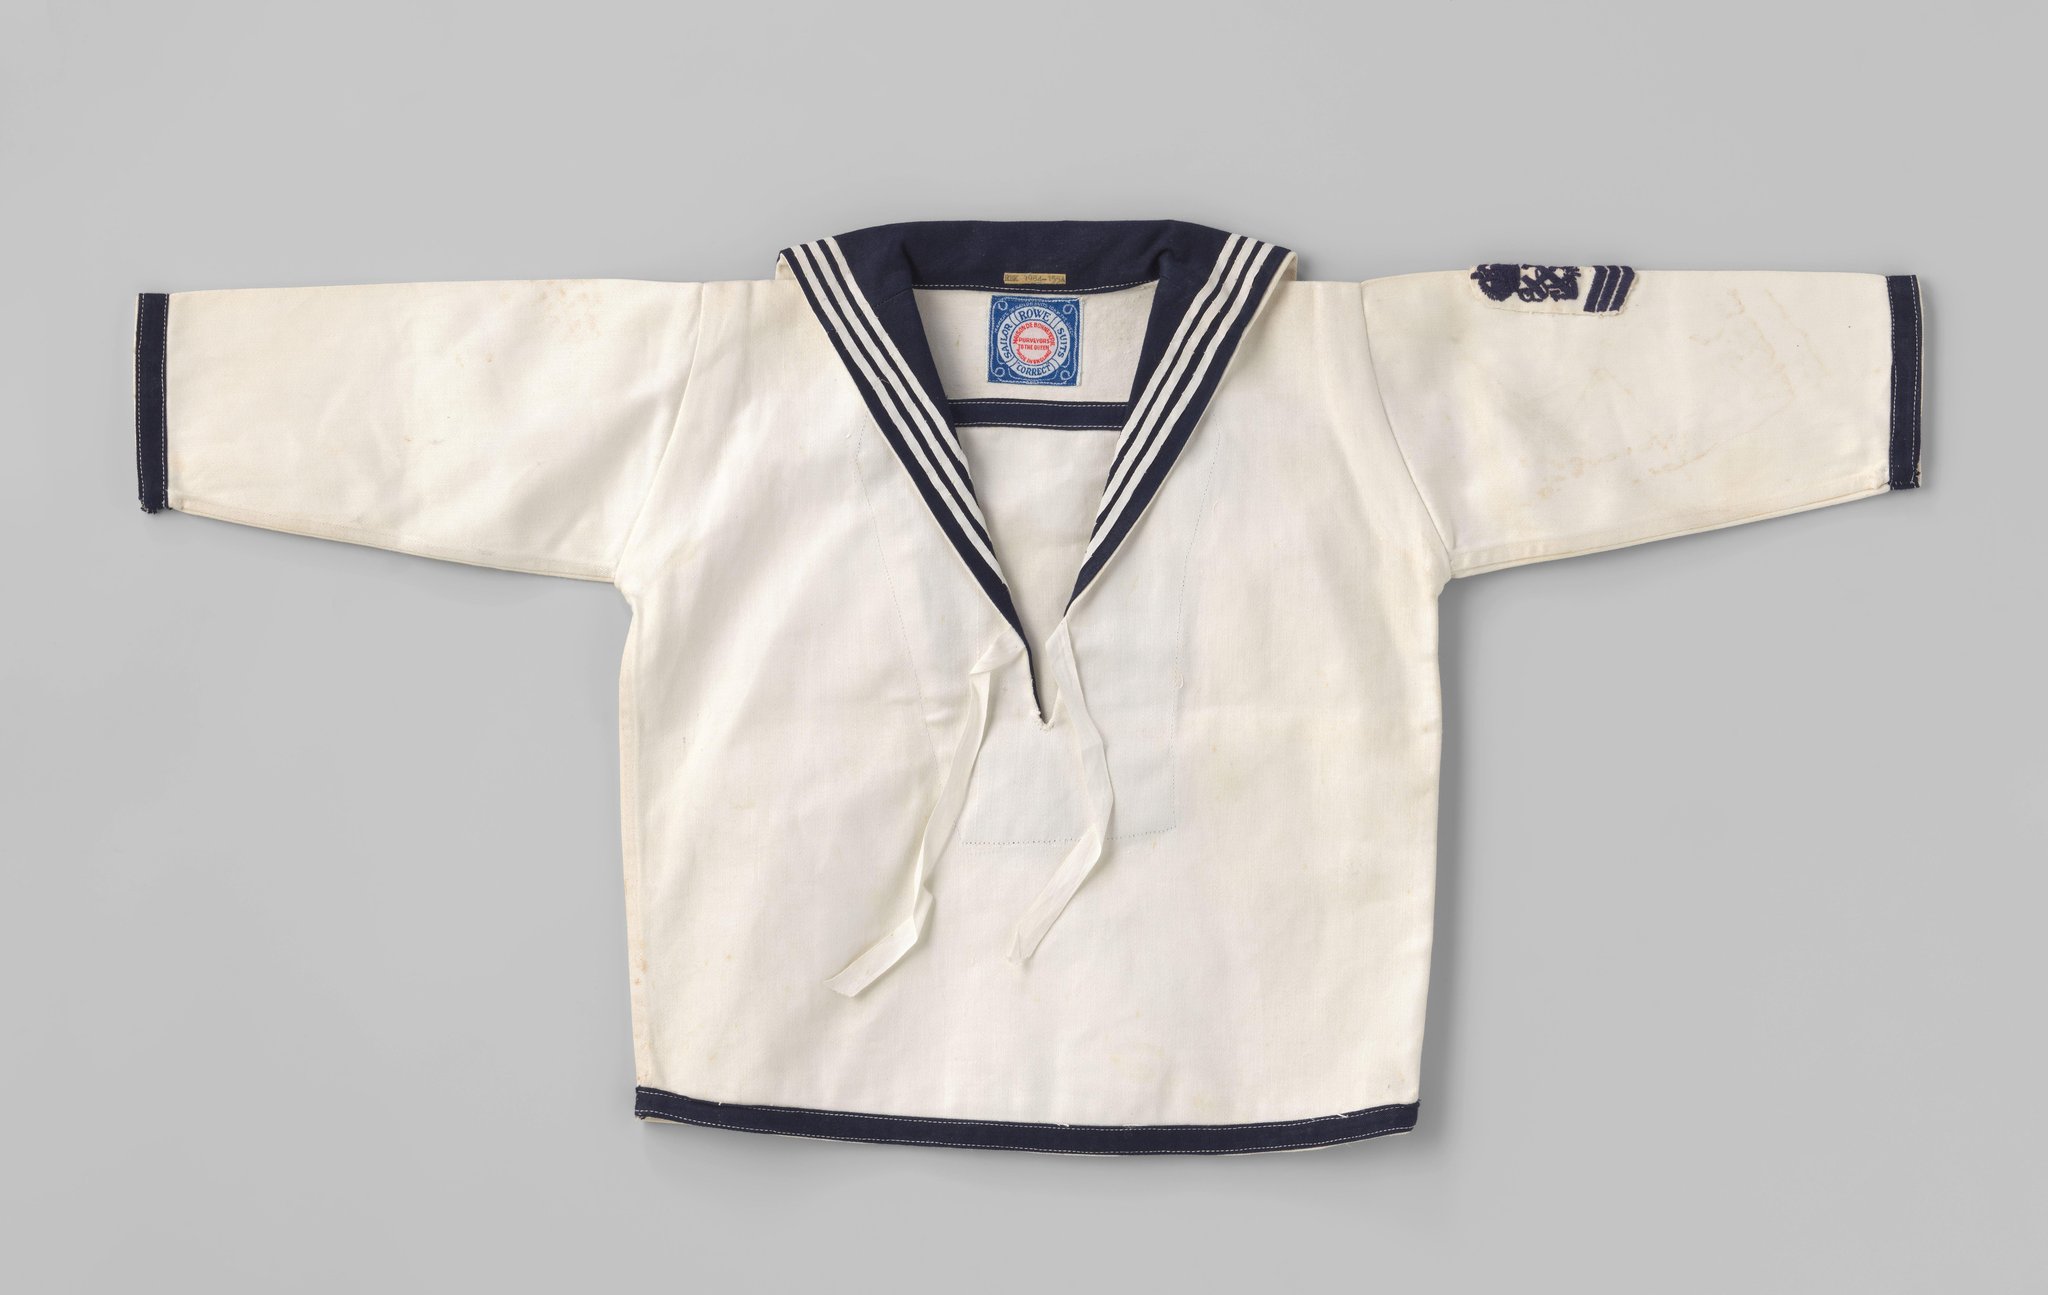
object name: childrenswear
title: Matrozenkiel van wit katoen, langs het vestje, de mouwen en de zoom met blauwe soutache; blauwe kraag met witte soutache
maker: william rowe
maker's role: designer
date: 1930-1940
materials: cotton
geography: gosport